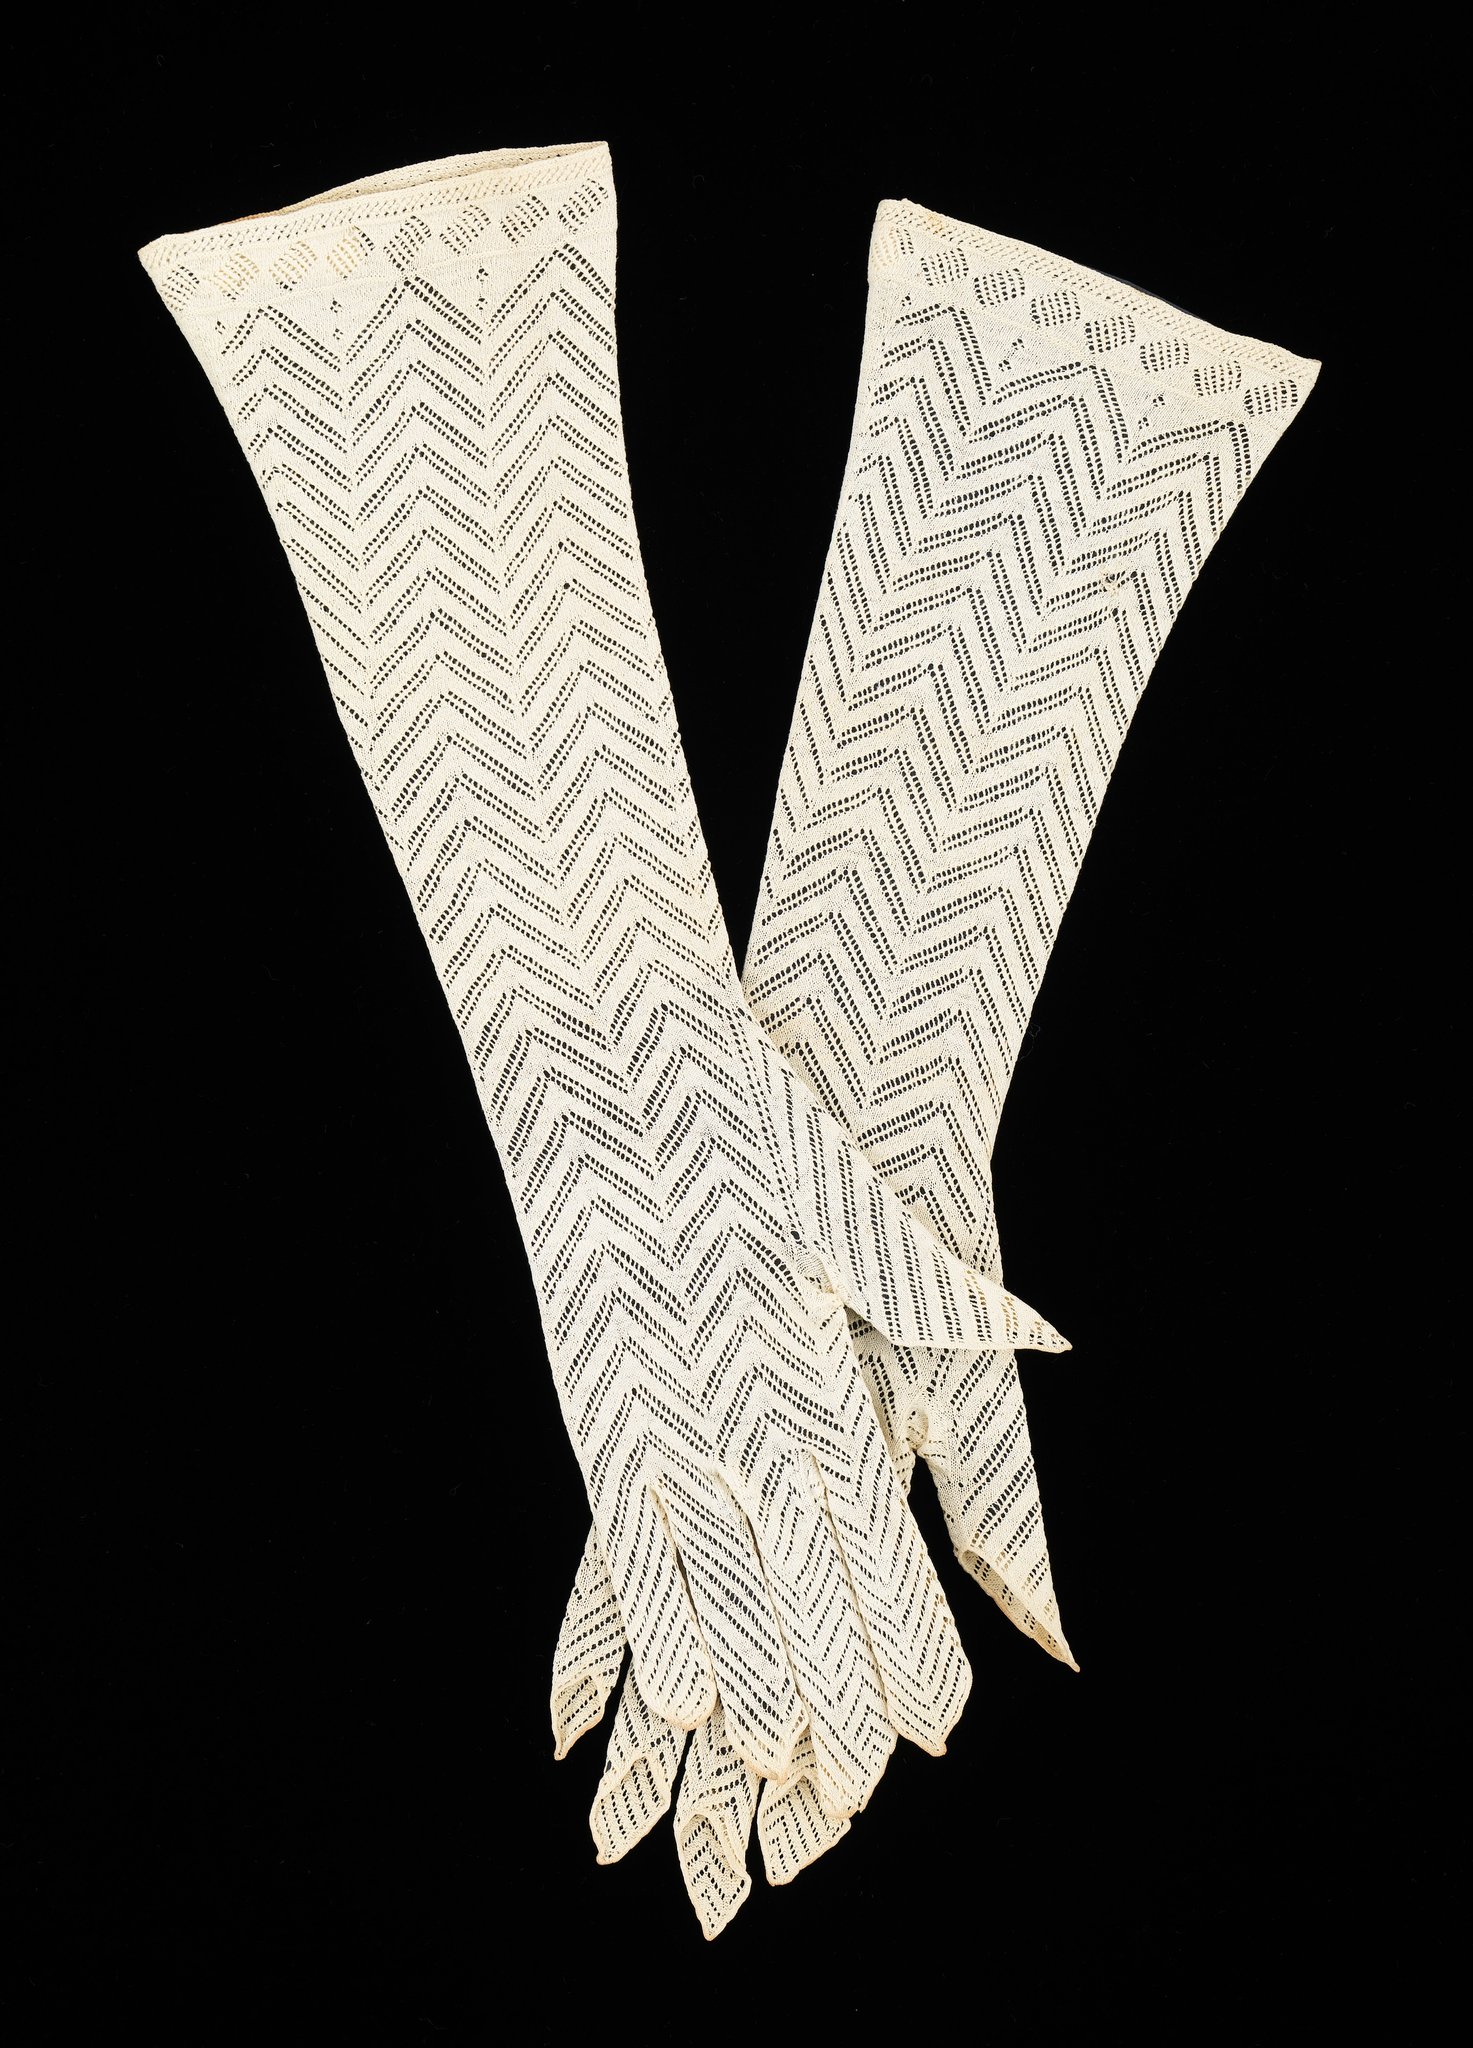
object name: evening glove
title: Evening gloves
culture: american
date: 1830-1835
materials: cotton